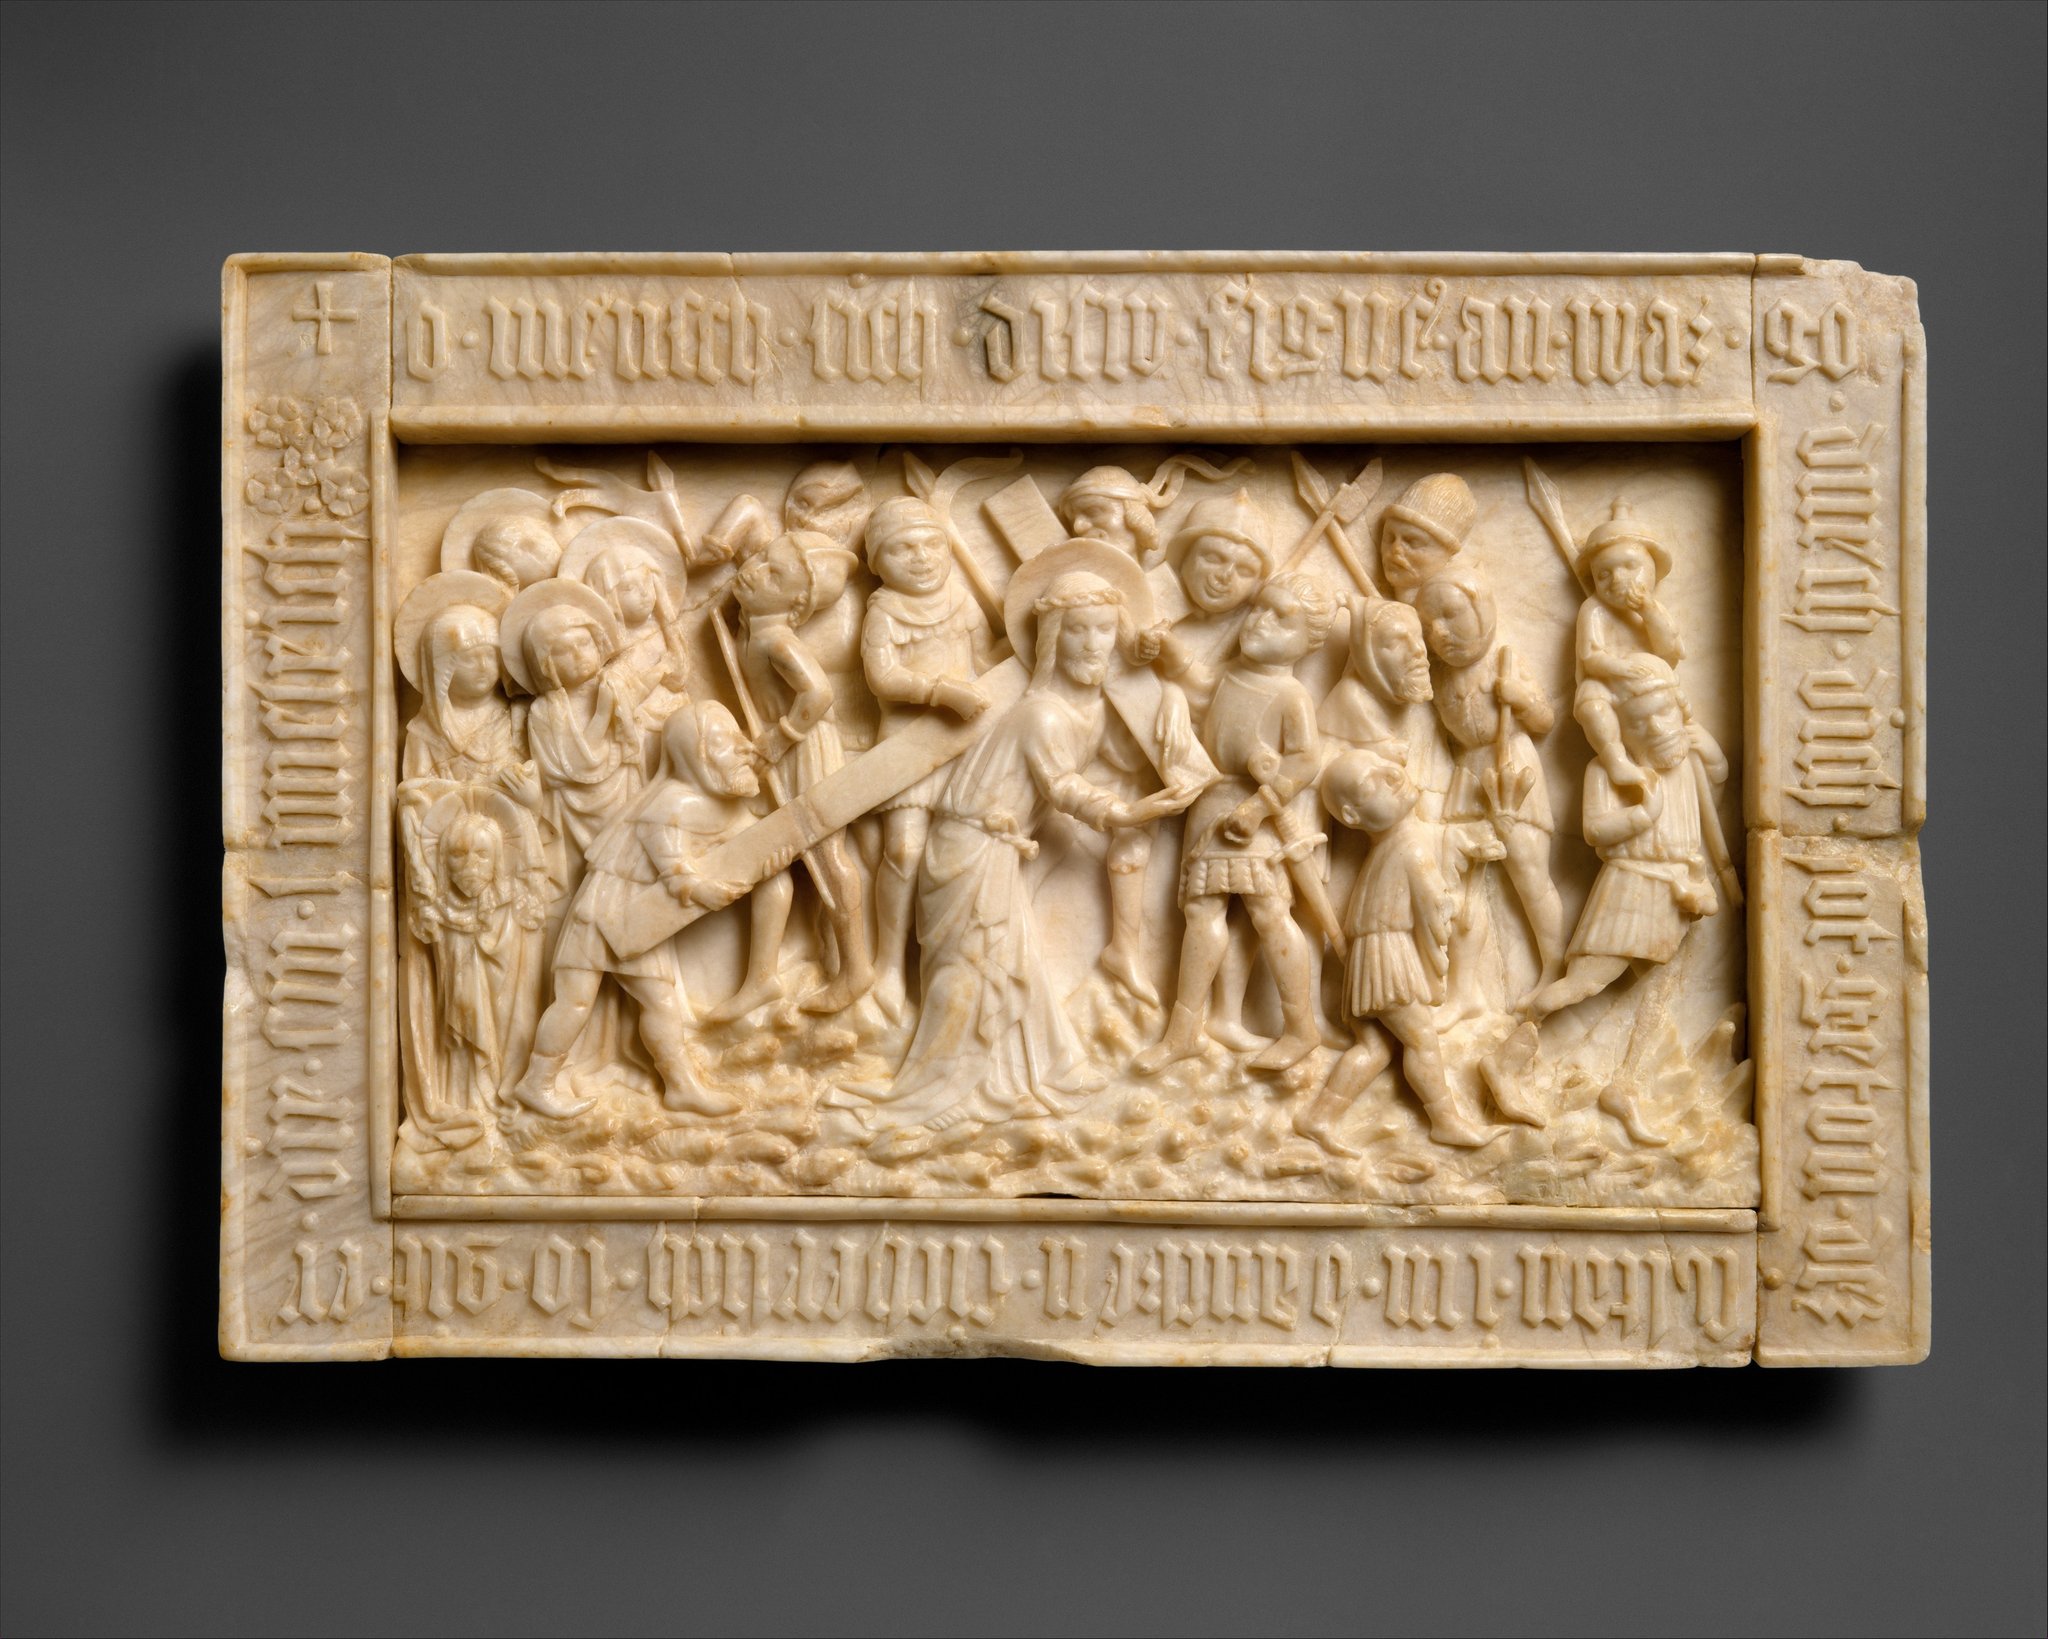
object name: relief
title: The Road to Calvary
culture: german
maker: master of the lorsch calvary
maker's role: artist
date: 1440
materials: alabaster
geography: germany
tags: men,christ,bearing the cross